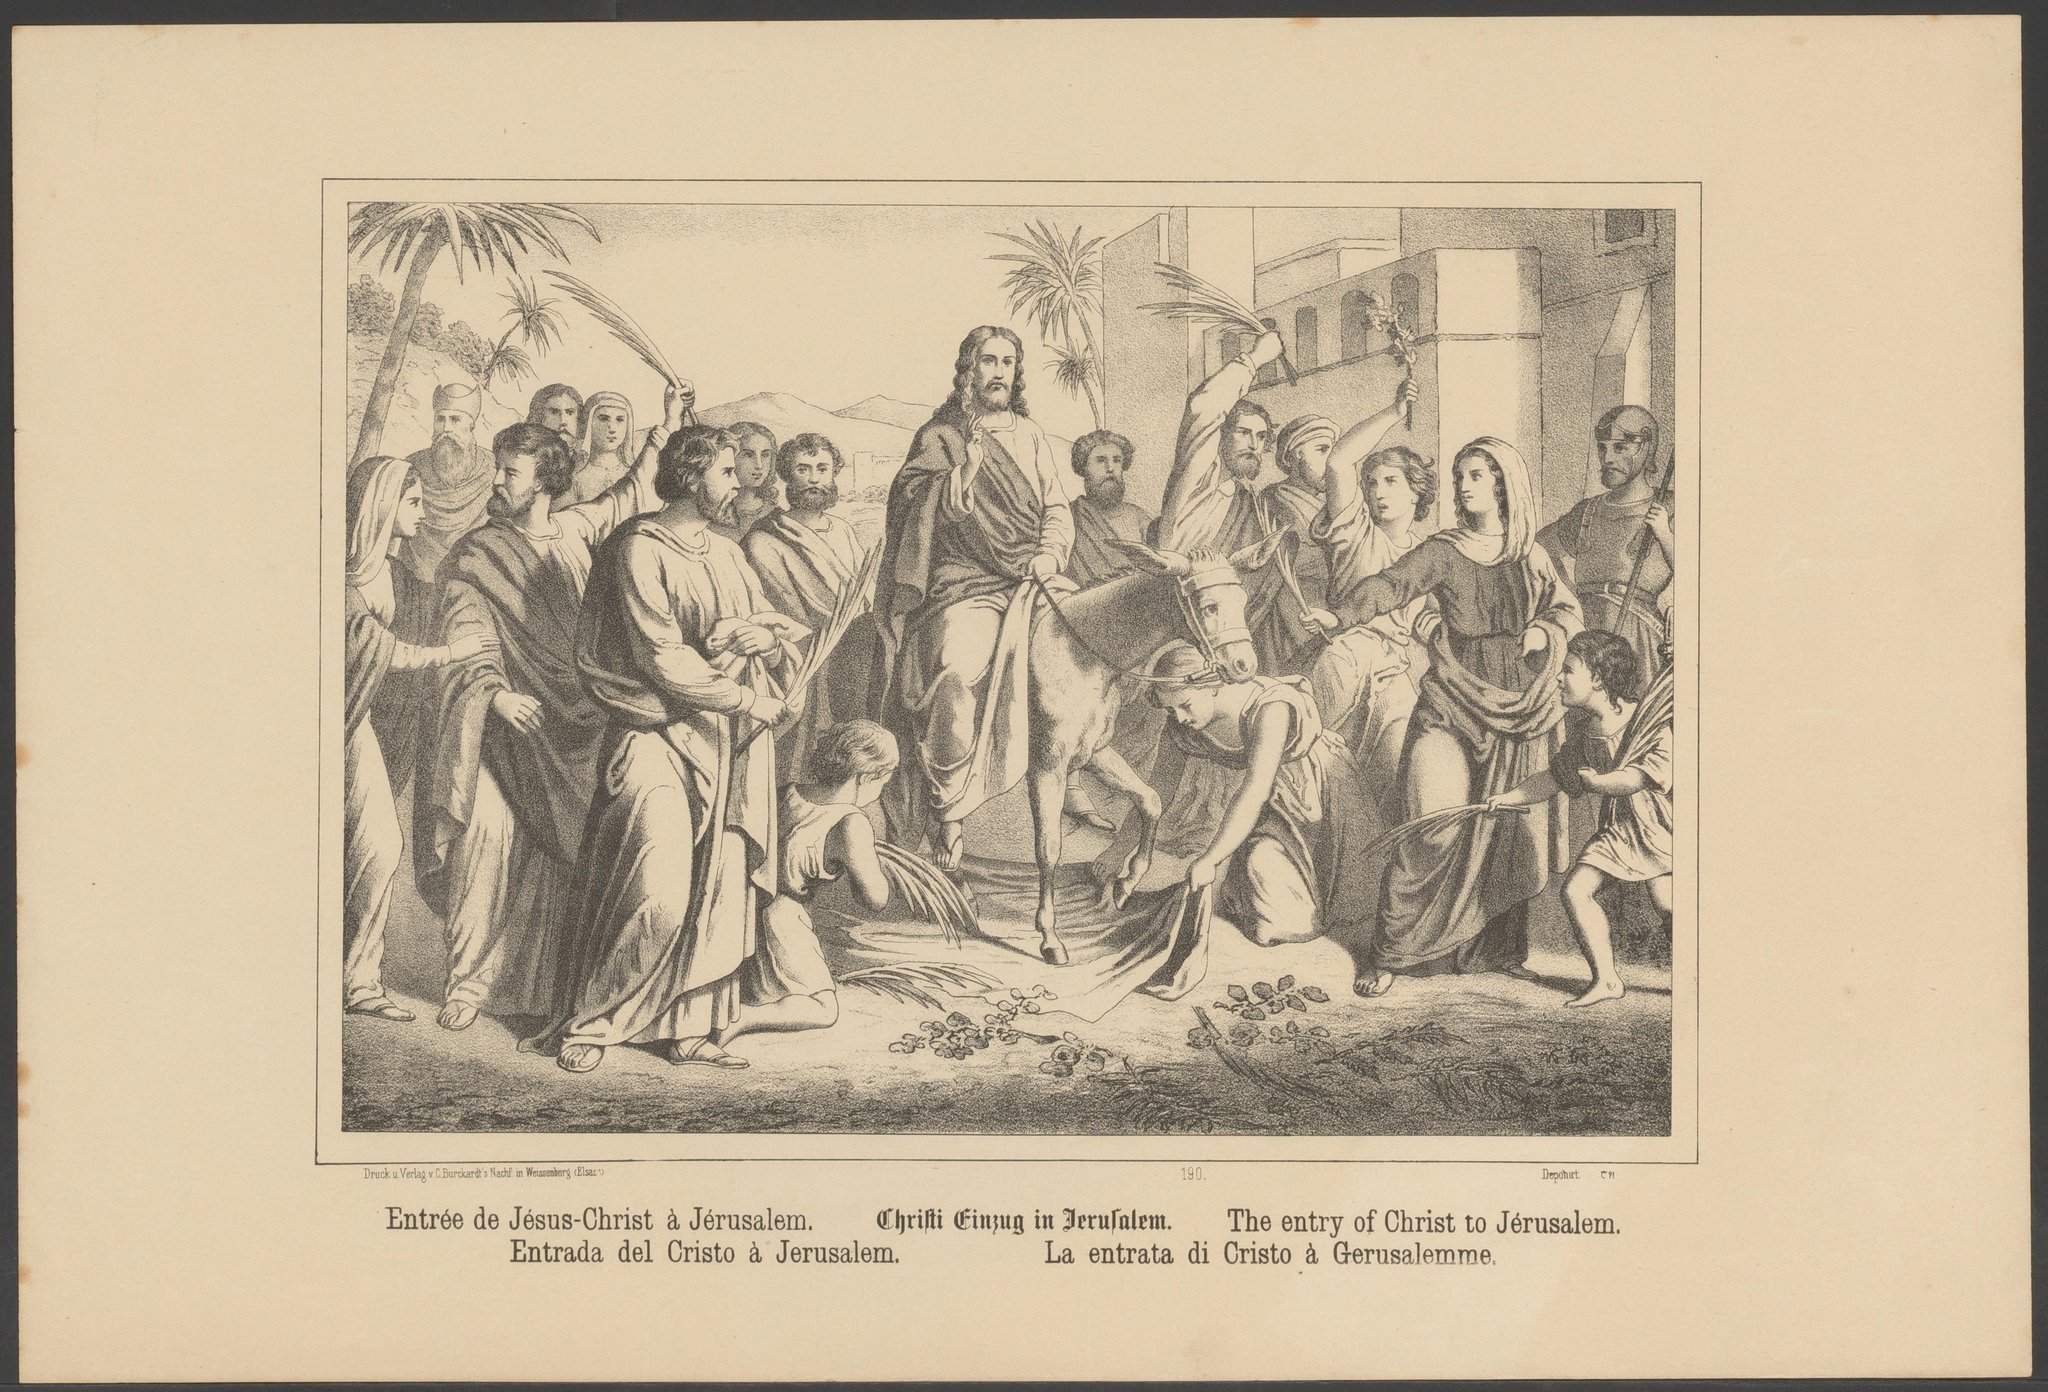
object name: print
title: Intocht in Jeruzalem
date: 1870-1906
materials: paper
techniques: lithograph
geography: wissembourg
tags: entry into jerusalem: people spreading their clothes before christ on the ass, and waving palm branches (matthew 21:1-11, 21:14-16; mark 11:1-11; luke 19:28-40; john 12:12-19)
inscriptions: stamp, collector's mark: Lugt 2233, collector's mark: Lugt 1641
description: Onderaan genummerd: 190. Onderwerpsrubrieken binnen de Atlas Zeden en Gewoonten: Godsdienst, Figuren van Christus en heiligen.